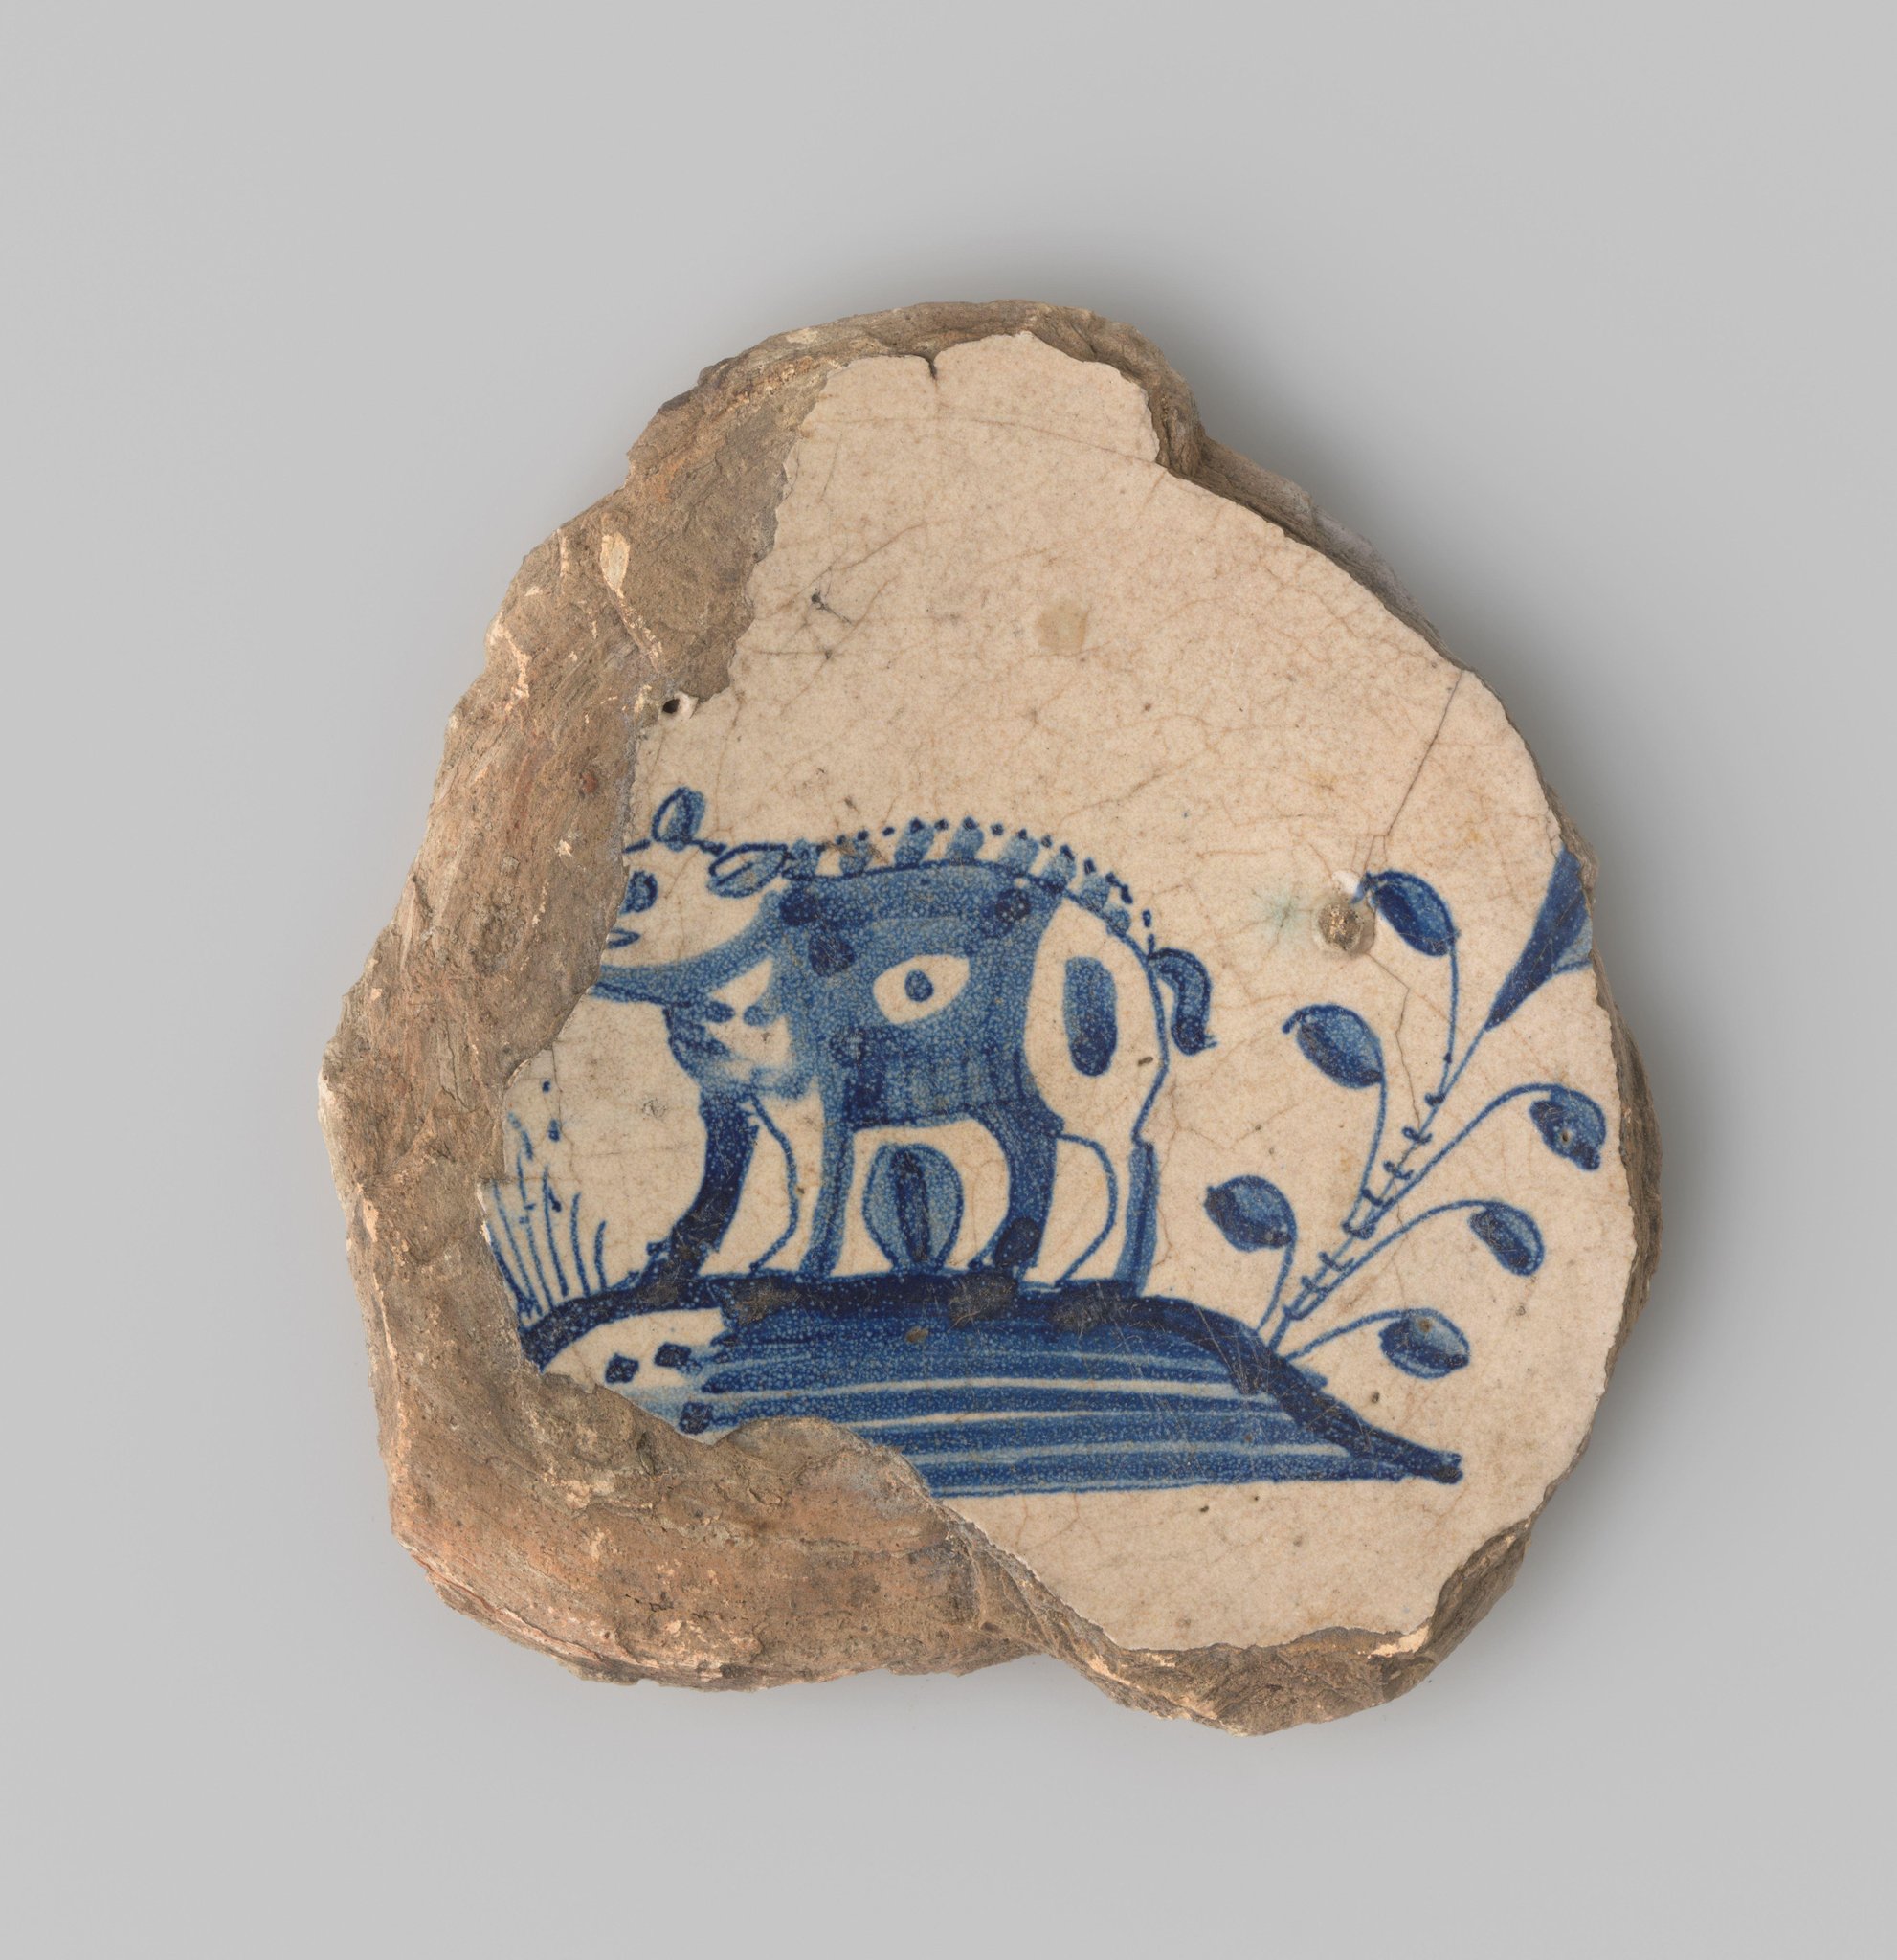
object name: sherd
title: Schotelfragment van aardewerk voorzien van loodglazuur aan de achterzijde en tinglazuur met blauwe decoratie met een dier aan de voorzijde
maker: Anonymous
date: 1600-1620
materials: earthenware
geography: northern netherlands